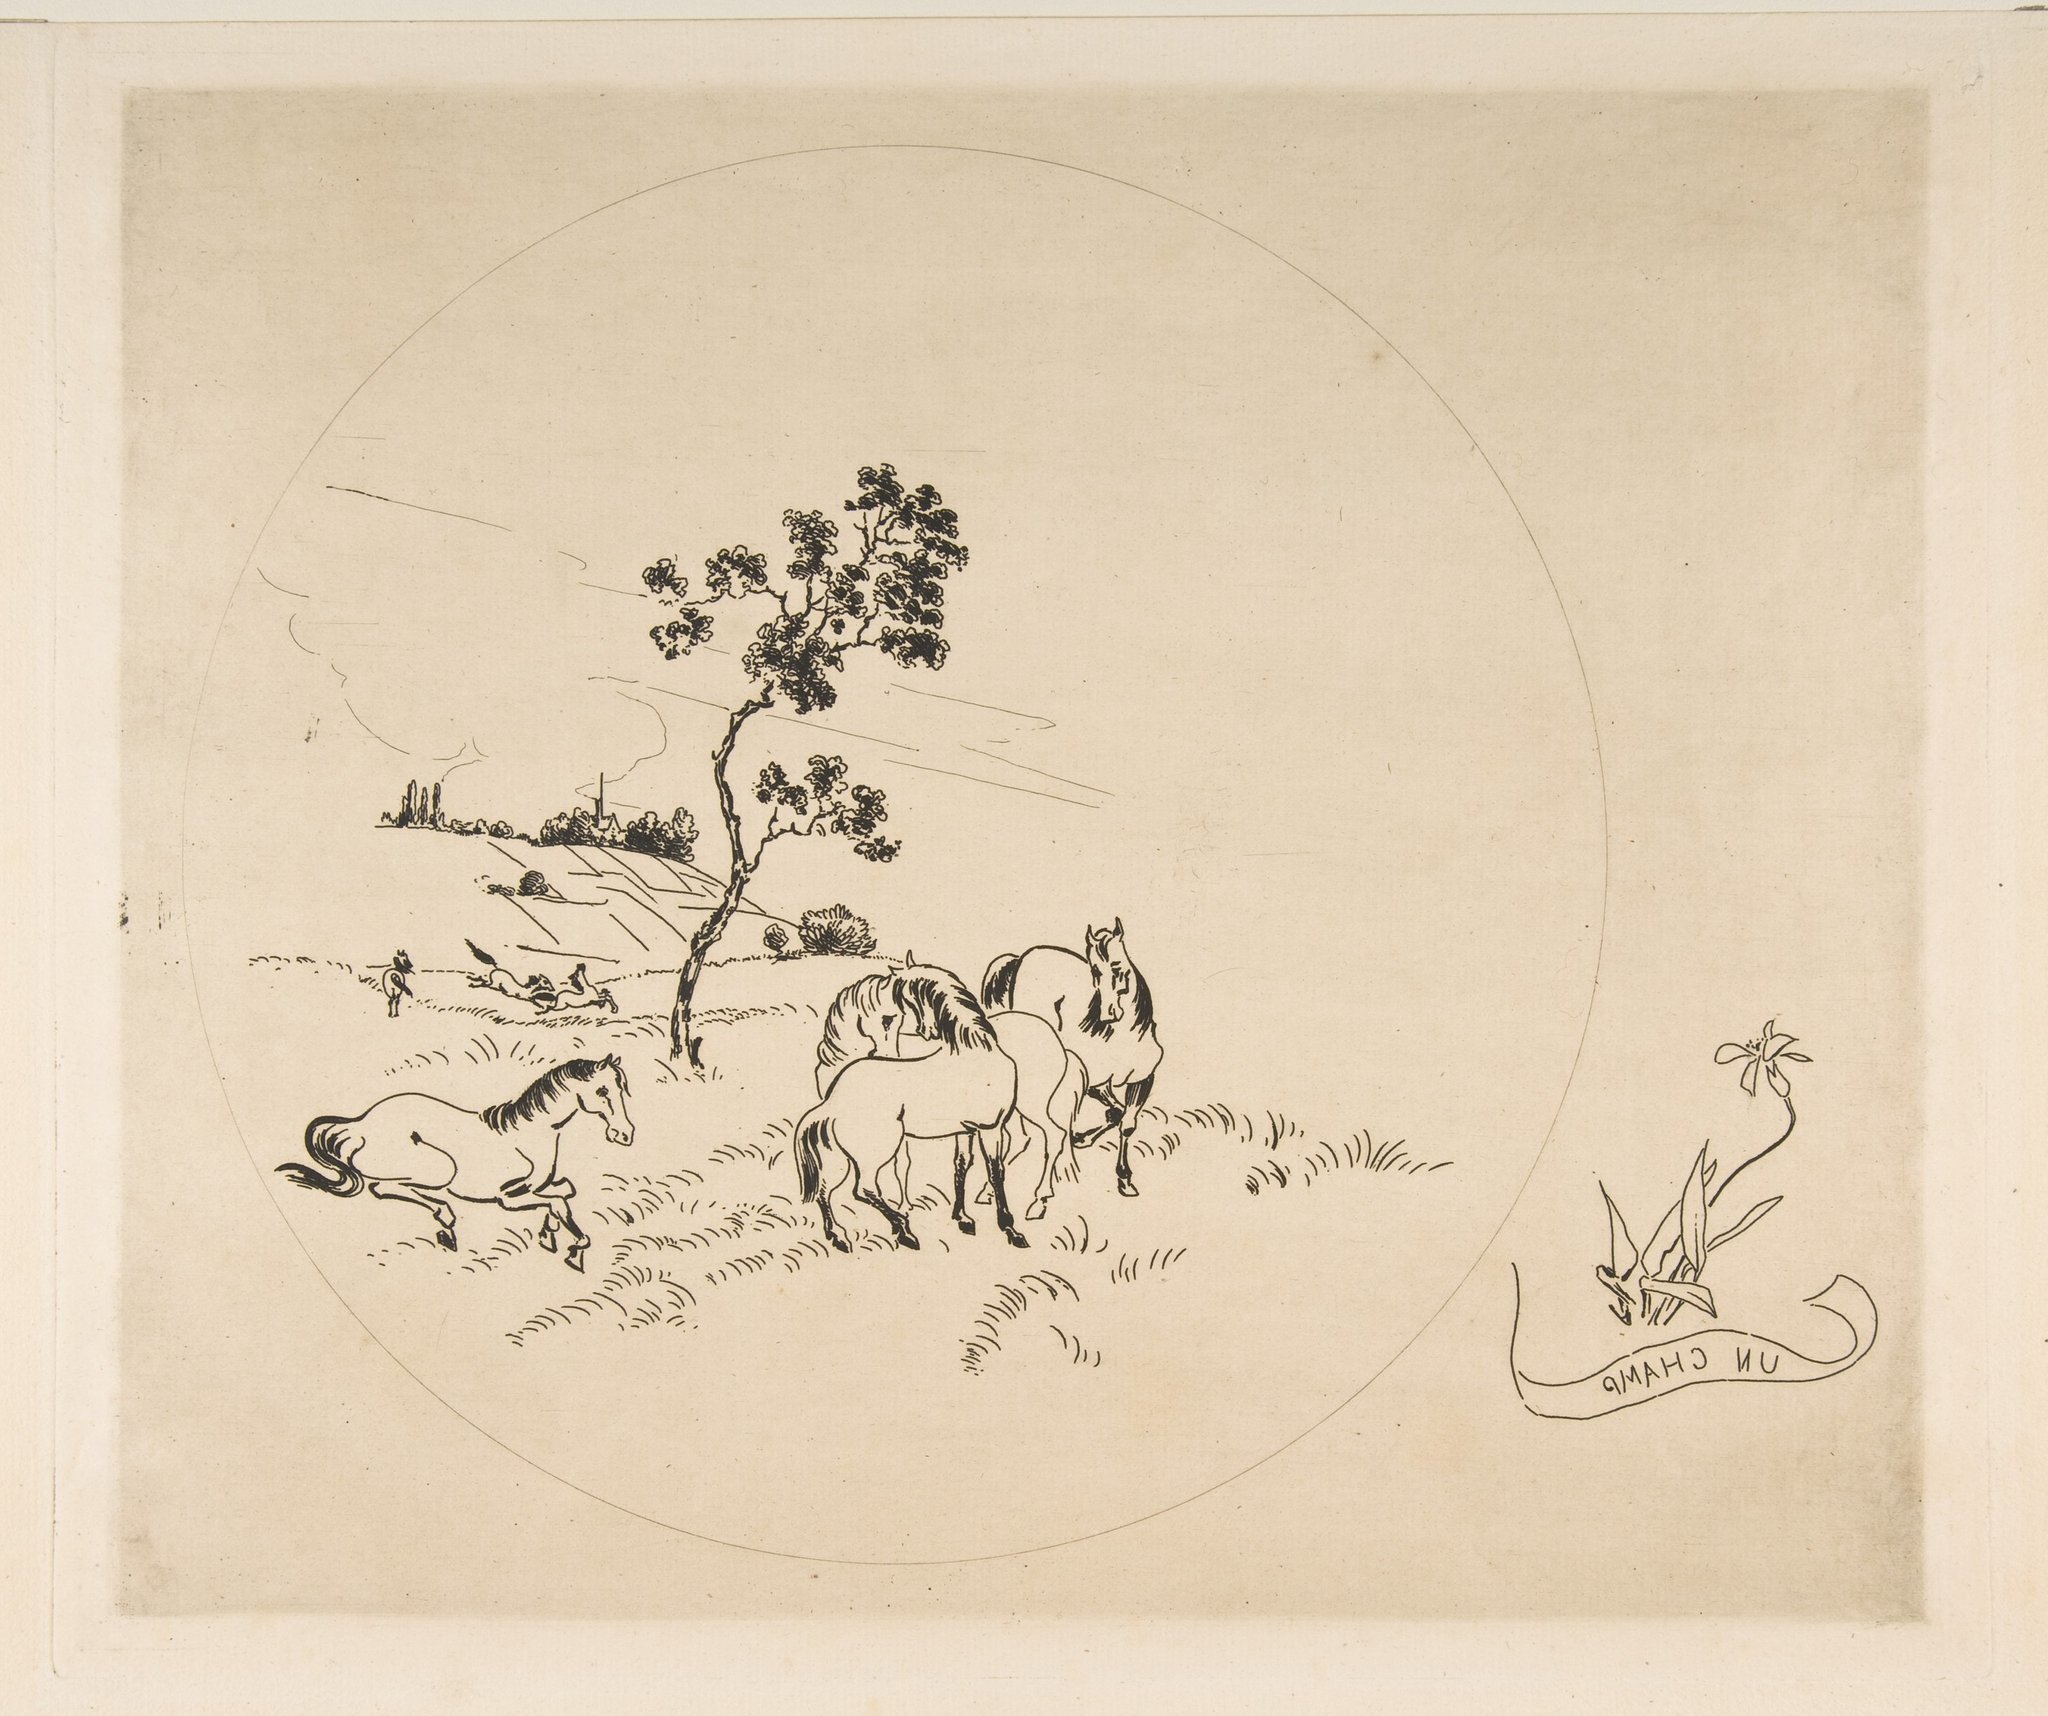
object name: print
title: Decoration for a Plate: A Field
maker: félix bracquemond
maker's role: artist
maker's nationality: french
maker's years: 1833-1914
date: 1870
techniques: etching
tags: horses,trees